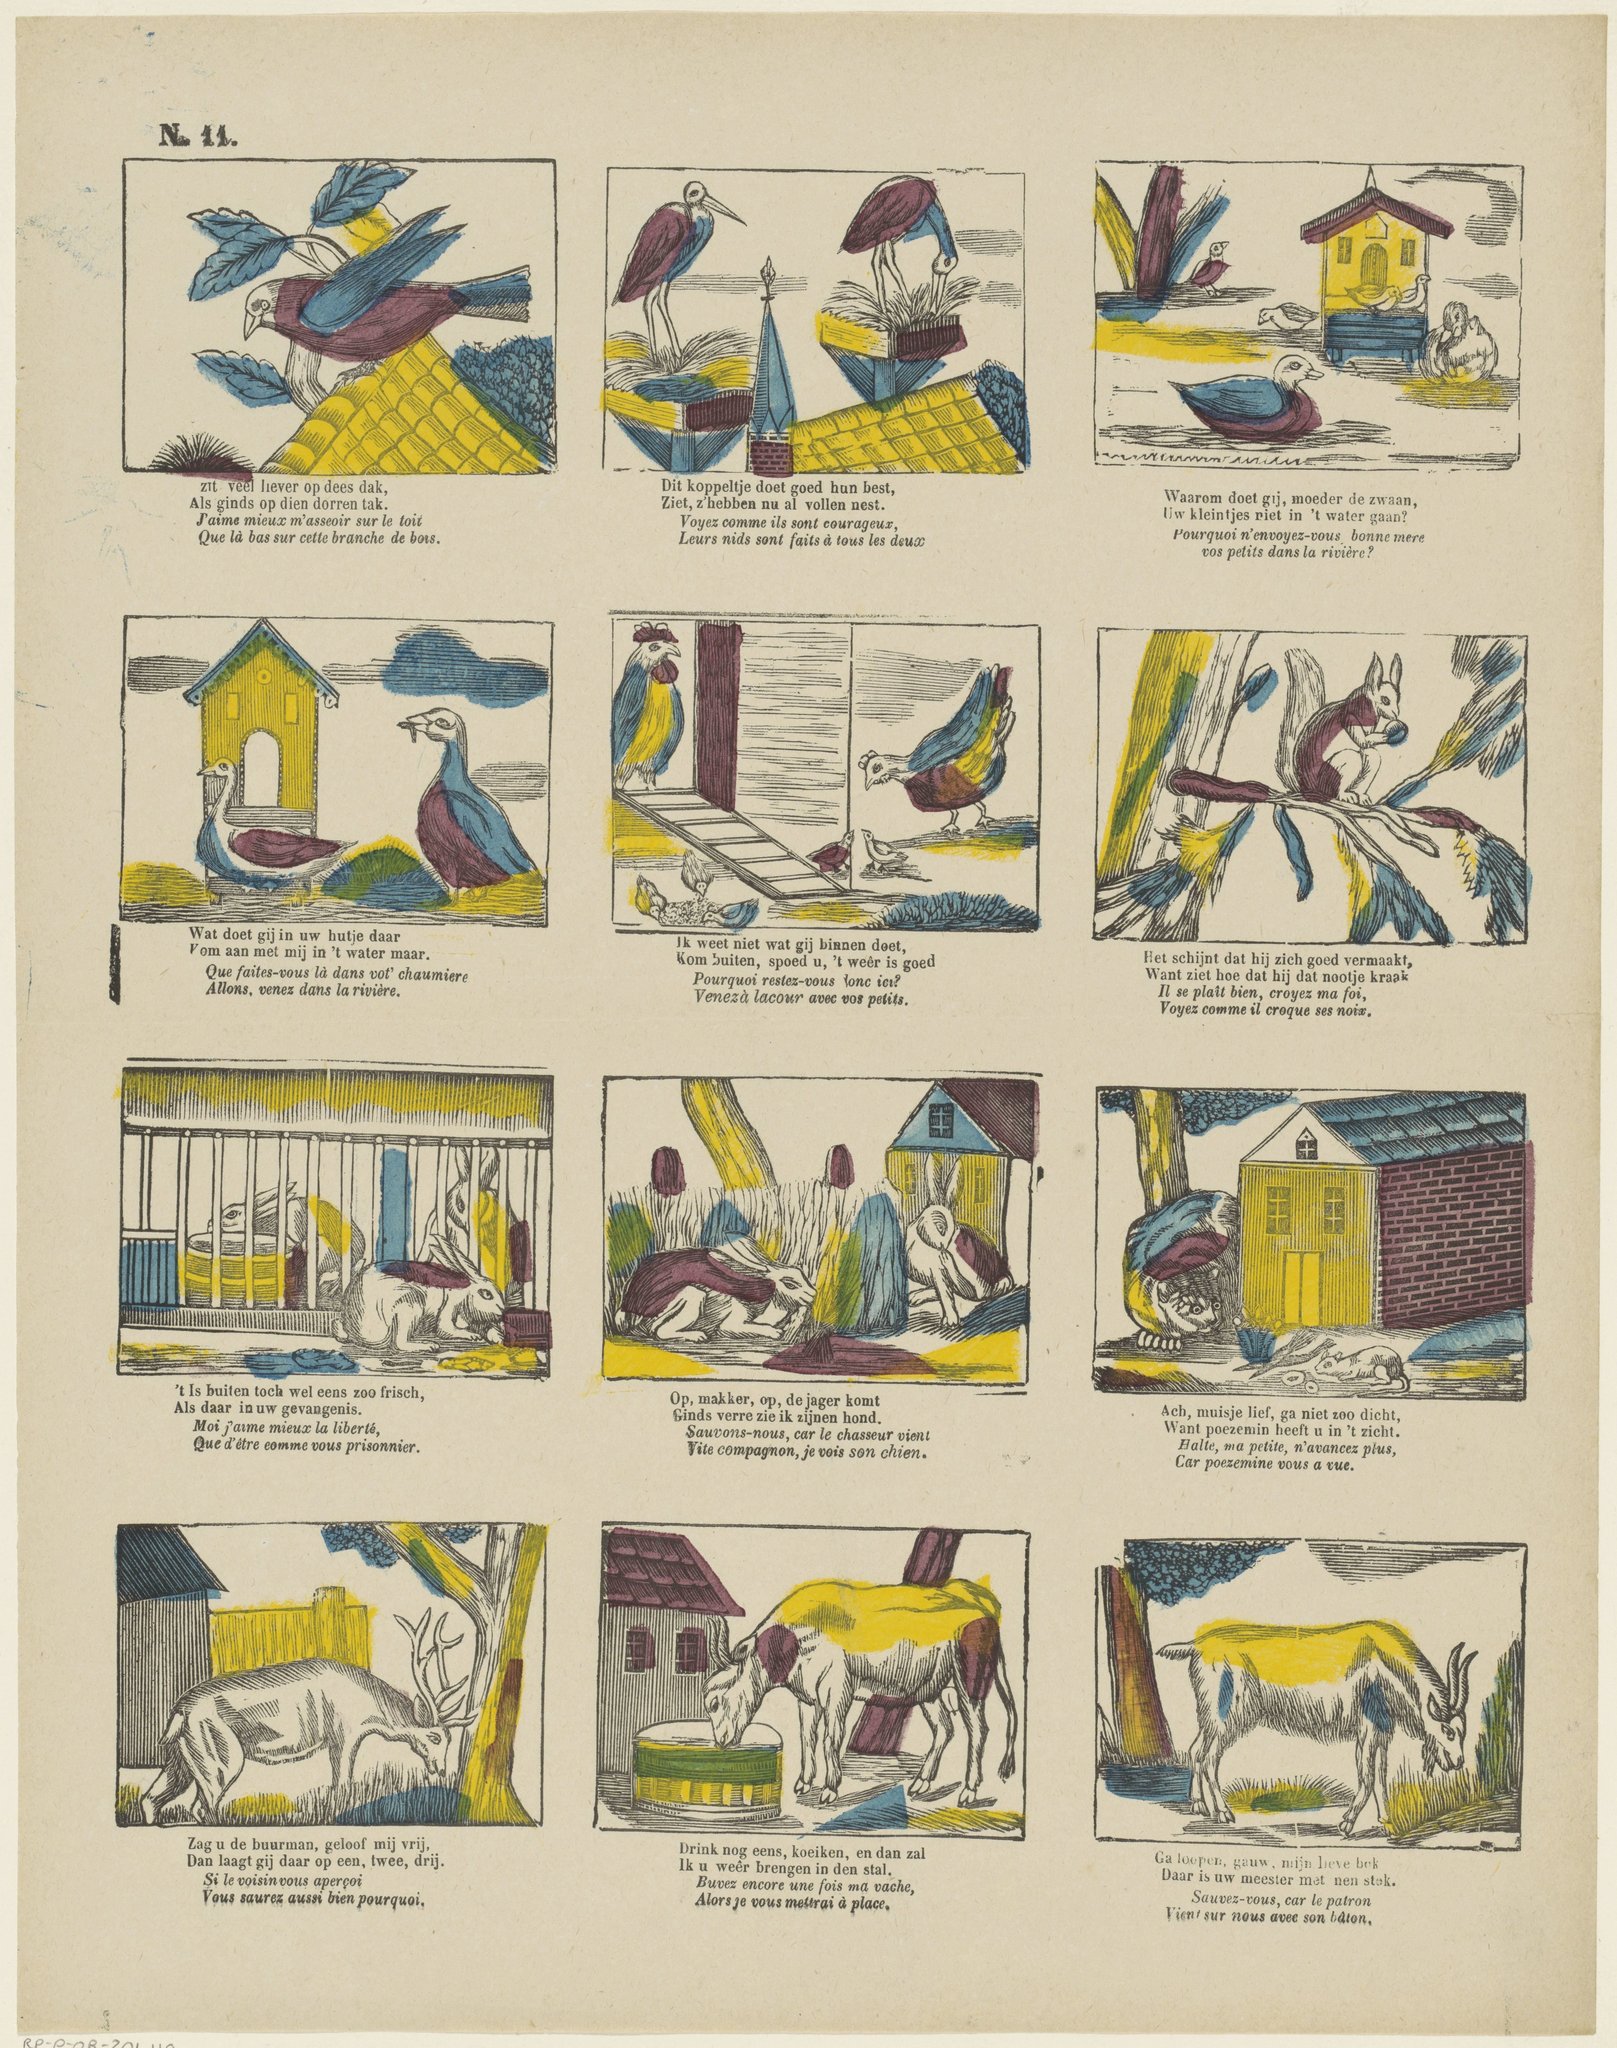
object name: popular print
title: Dieren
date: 1866-1902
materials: paper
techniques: colour, letterpress printing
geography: turnhout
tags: animals, birds, ram, fowl (cock, hen, chicken, etc.), rodents: rabbit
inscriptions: collector's mark: Lugt 2760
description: Blad met 12 voorstellingen van dieren, bijvoorbeeld vogels, een eekhoorn, konijnen en een bok. Onder elke voorstelling een tweeregelig vers in het Nederlands en in het Frans. Genummerd linksboven: N. 11.